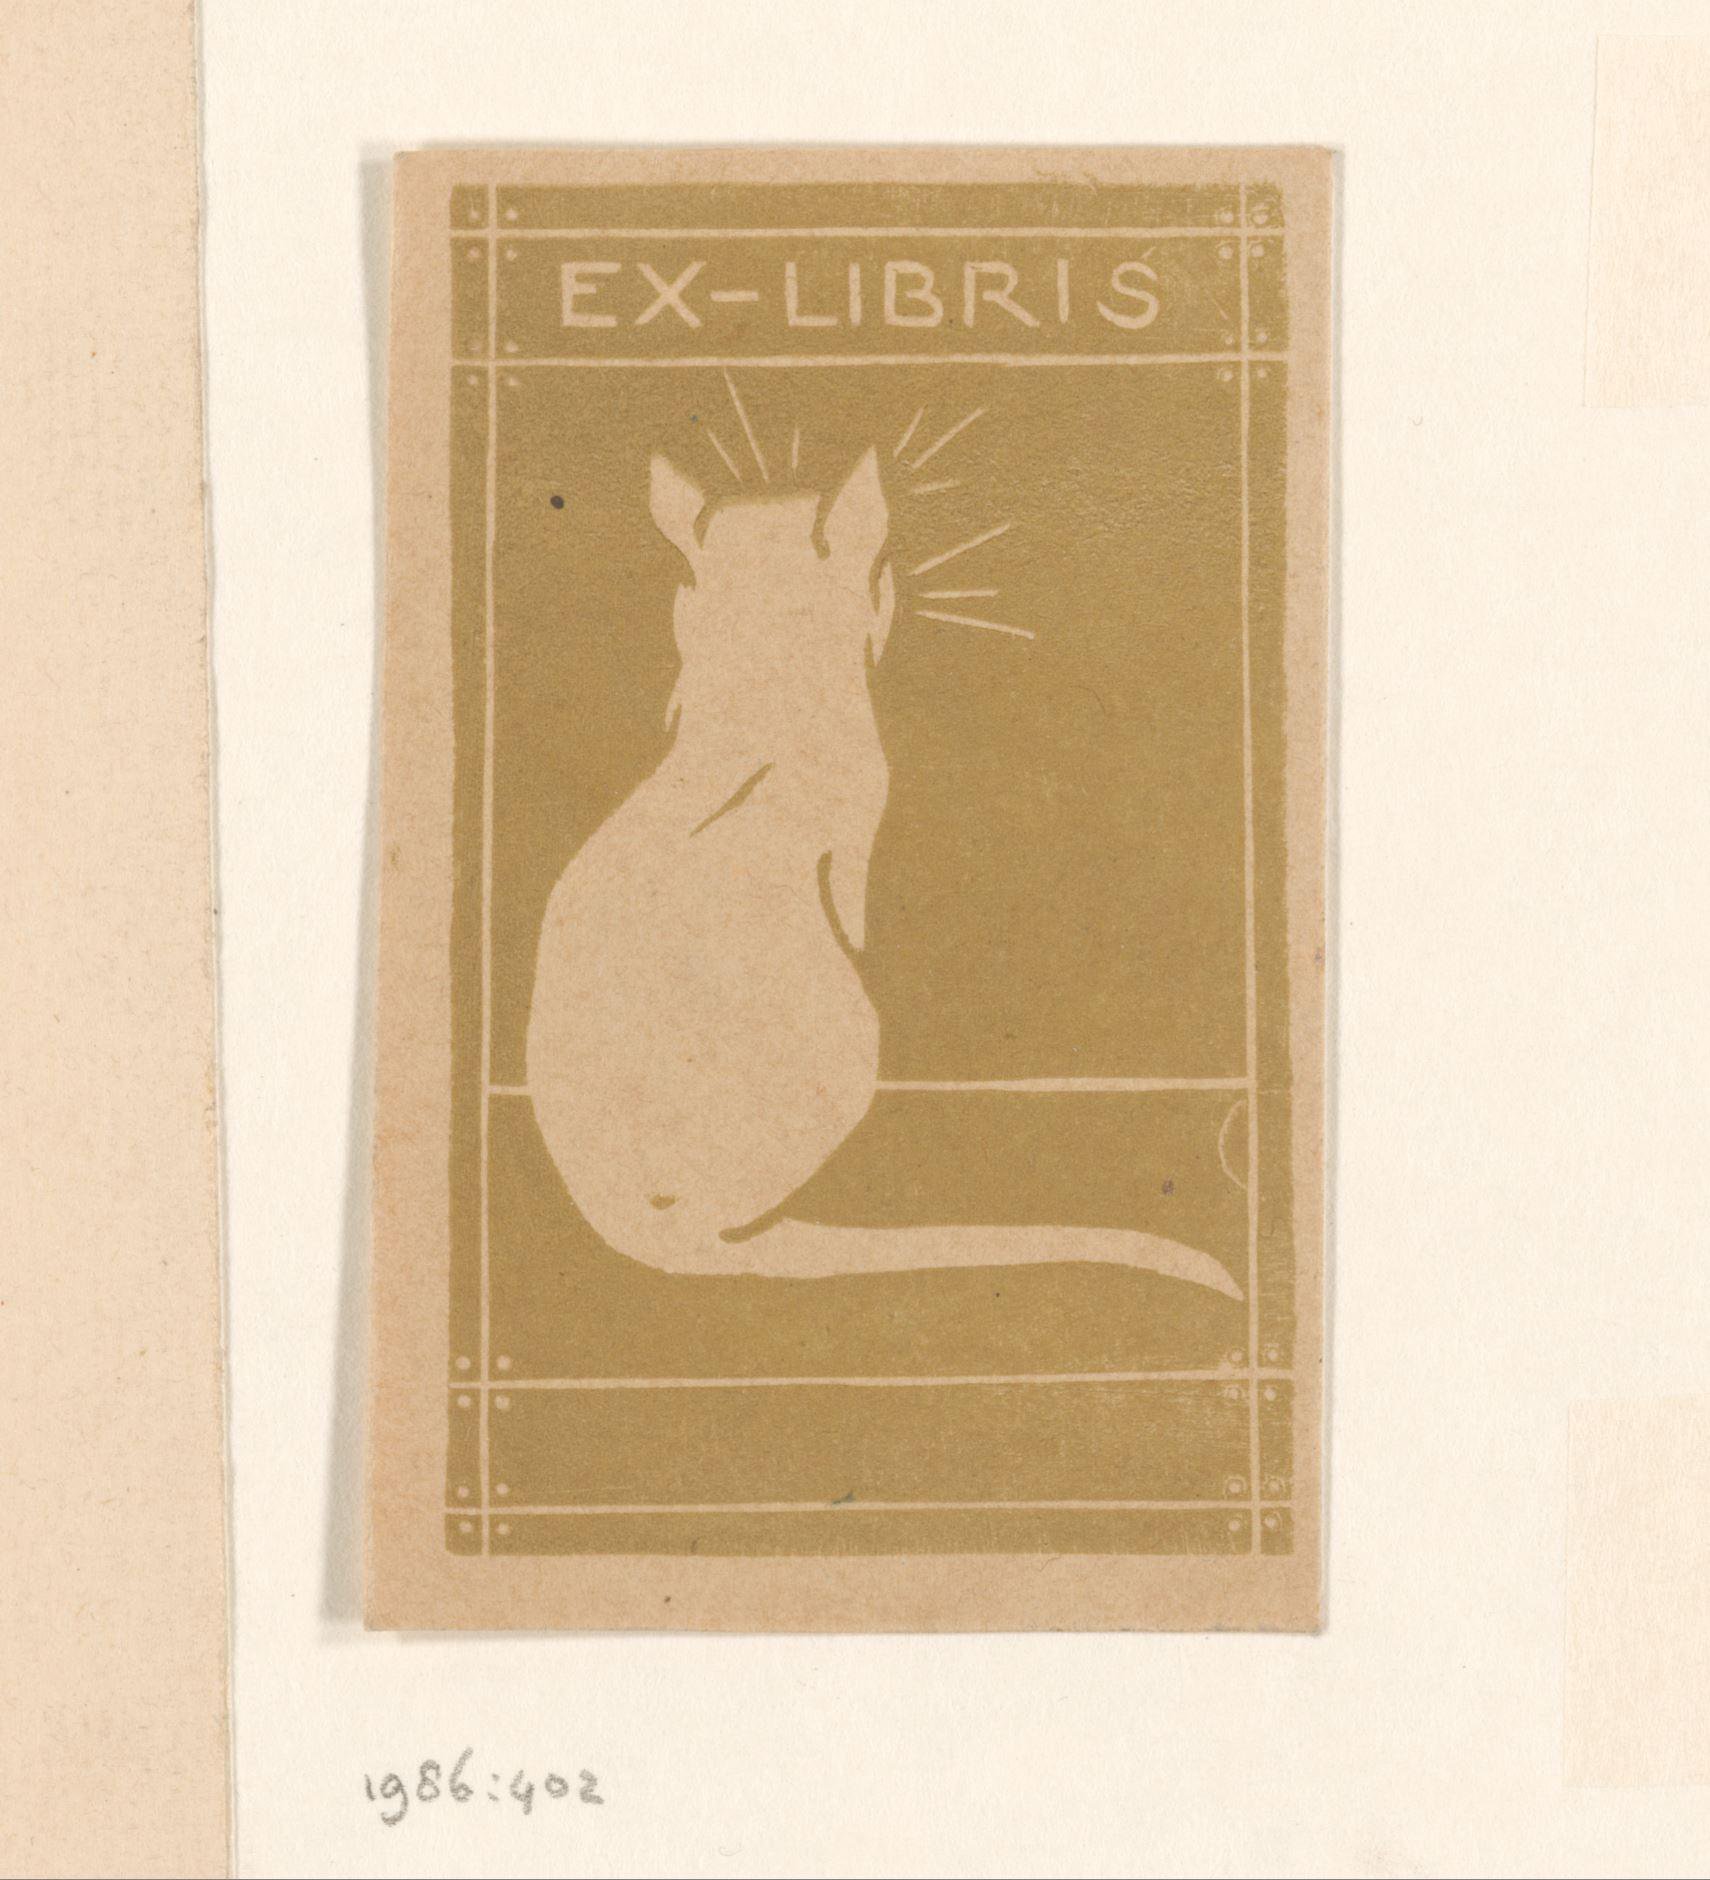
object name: bookplate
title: Ex libris met kat op de rug gezien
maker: reinier willem petrus de vries (1874-1953)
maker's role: draughtsman, print maker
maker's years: 1874-1953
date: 1884-1952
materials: paper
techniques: linocut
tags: cat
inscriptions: collector's mark: Lugt 2228